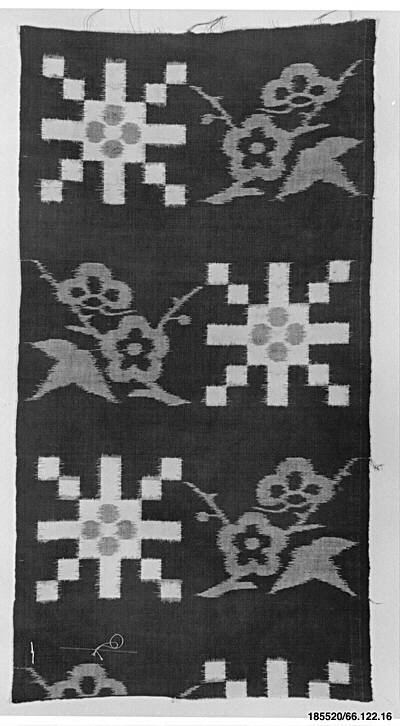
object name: piece of bedcloth fabric futon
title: Piece of Bedcloth Fabric (Futon)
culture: japanese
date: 1801-1900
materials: cotton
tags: flowers